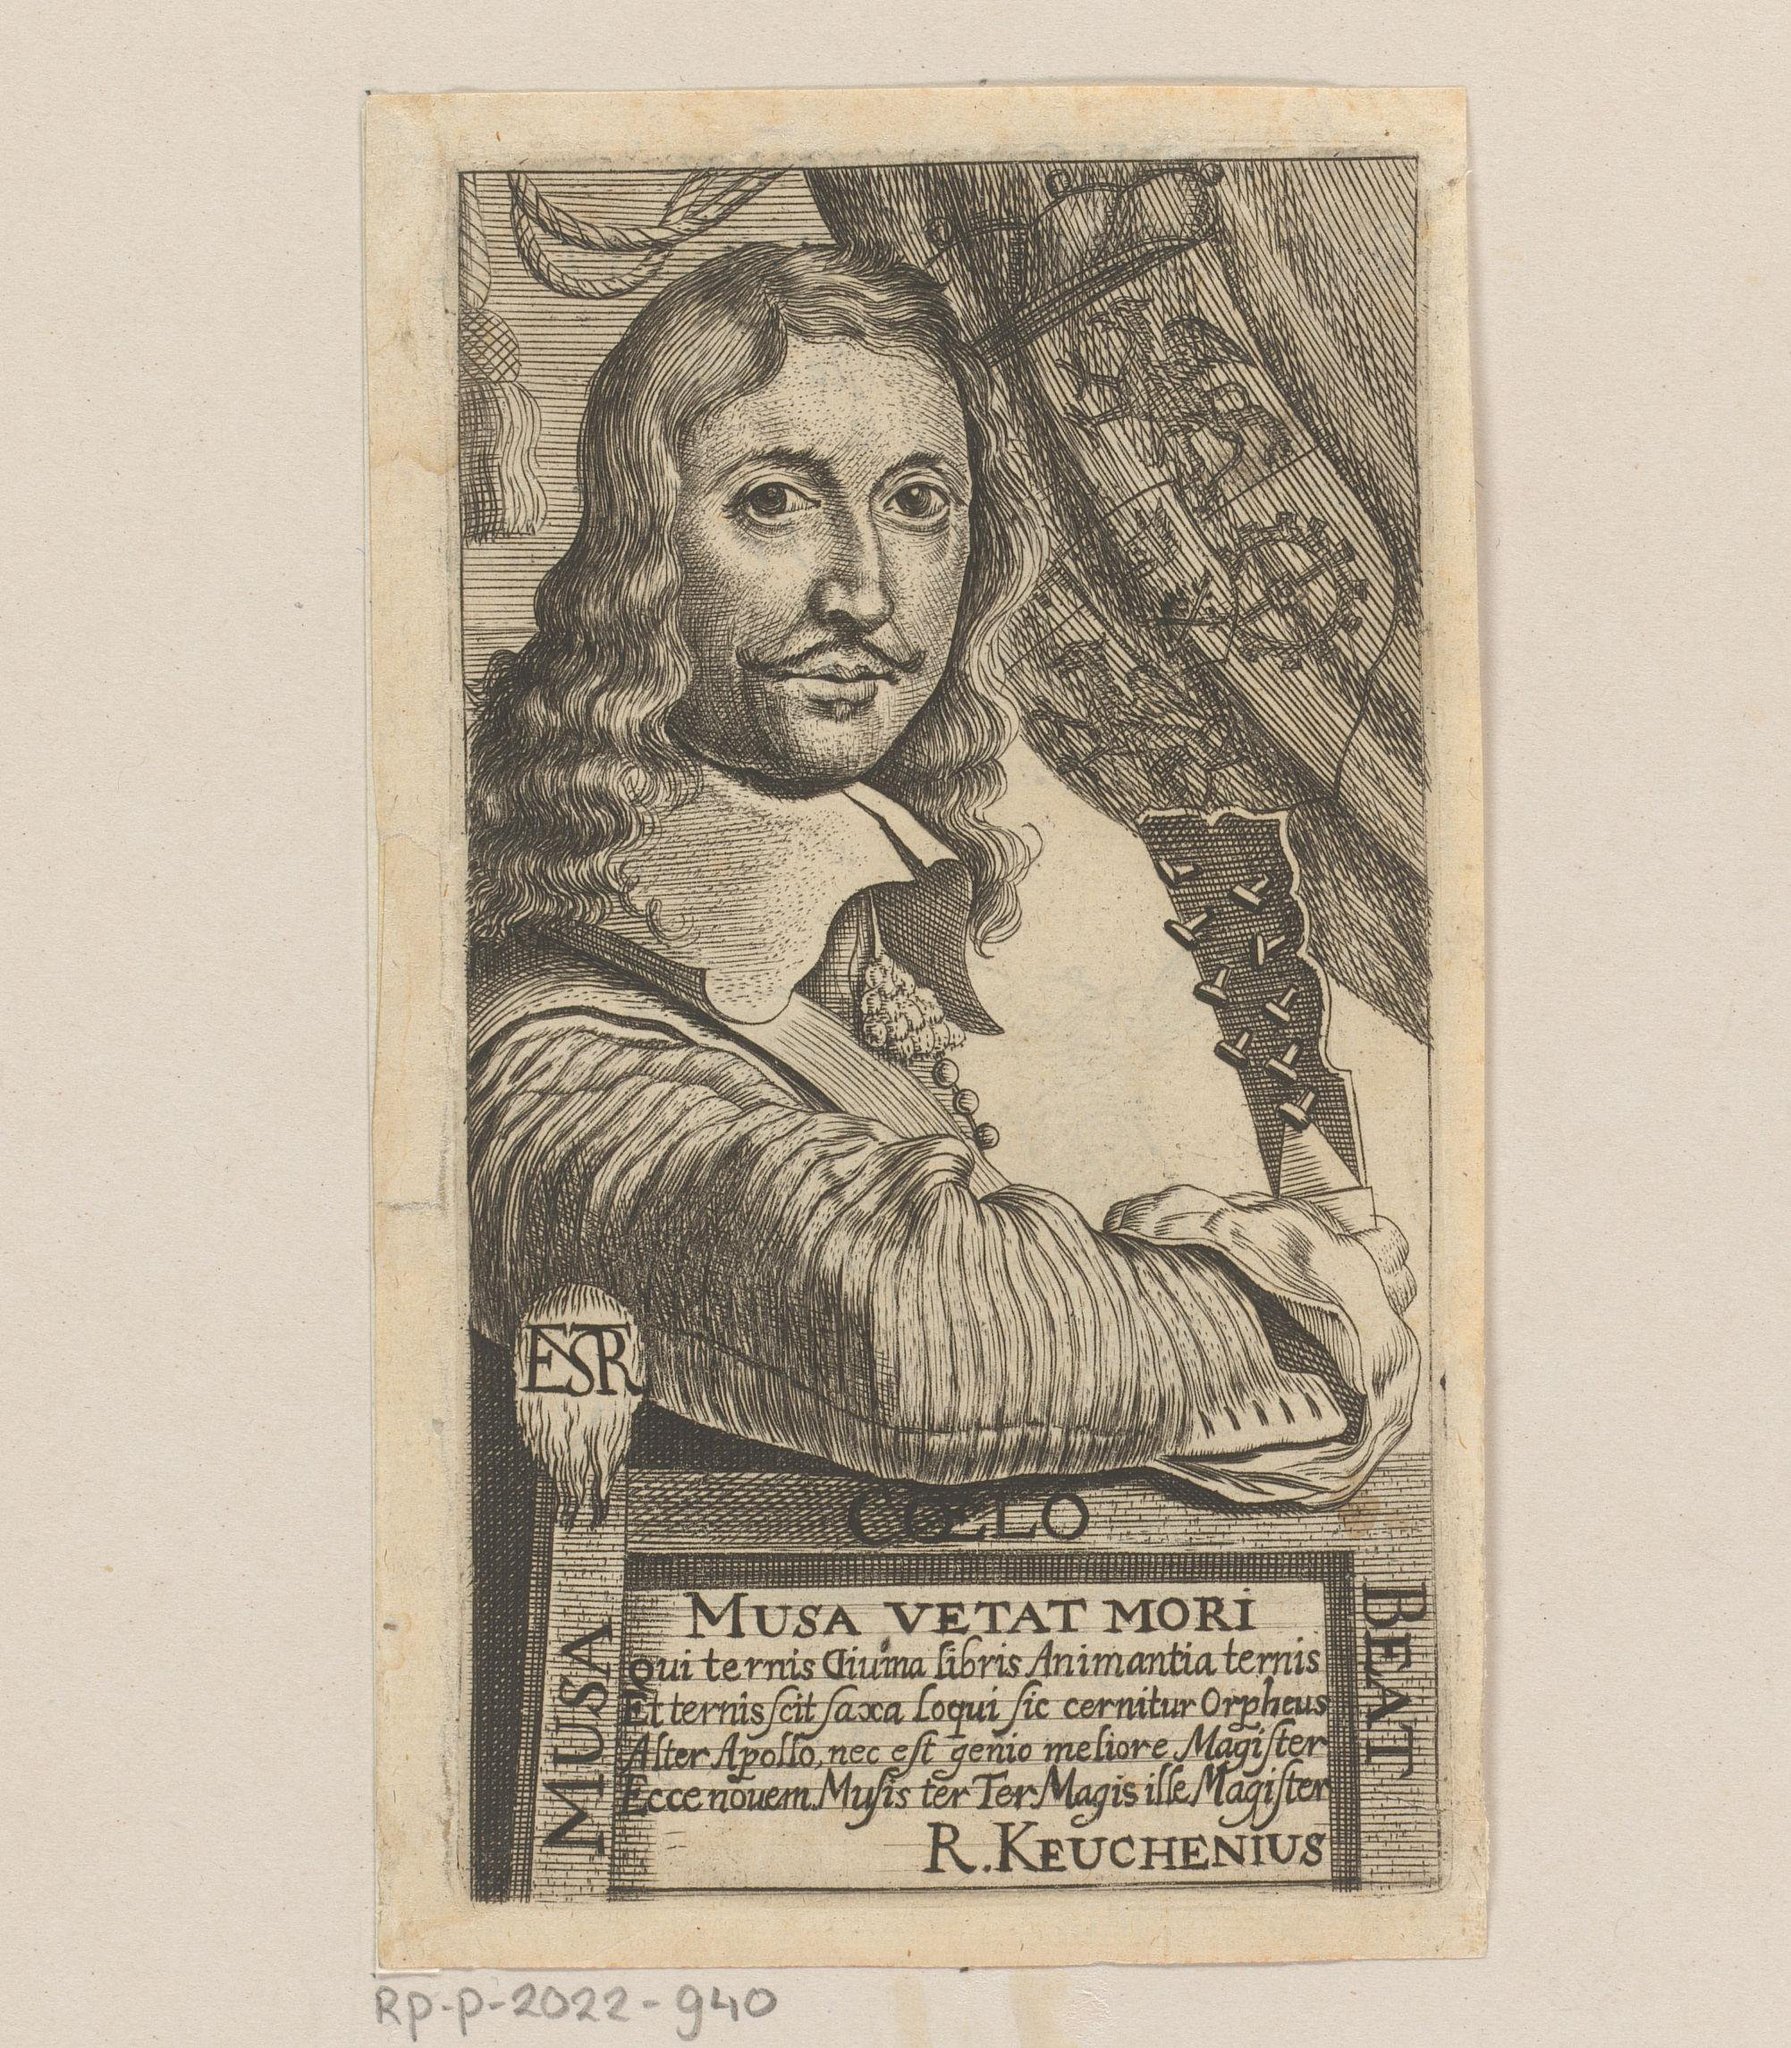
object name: print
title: Zelfportret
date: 1668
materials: paper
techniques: engraving, letterpress printing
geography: utrecht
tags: utrecht, print maker, everard meyster, writer, poet, author (+ portrait, self-portrait of artist), historical persons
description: Prent uit: Meyster, E. De gekroonde berymde policy. Zĳnde het eerste deel der Meysterlĳke werken. Utrecht: Johannes Ribbius, 1668.